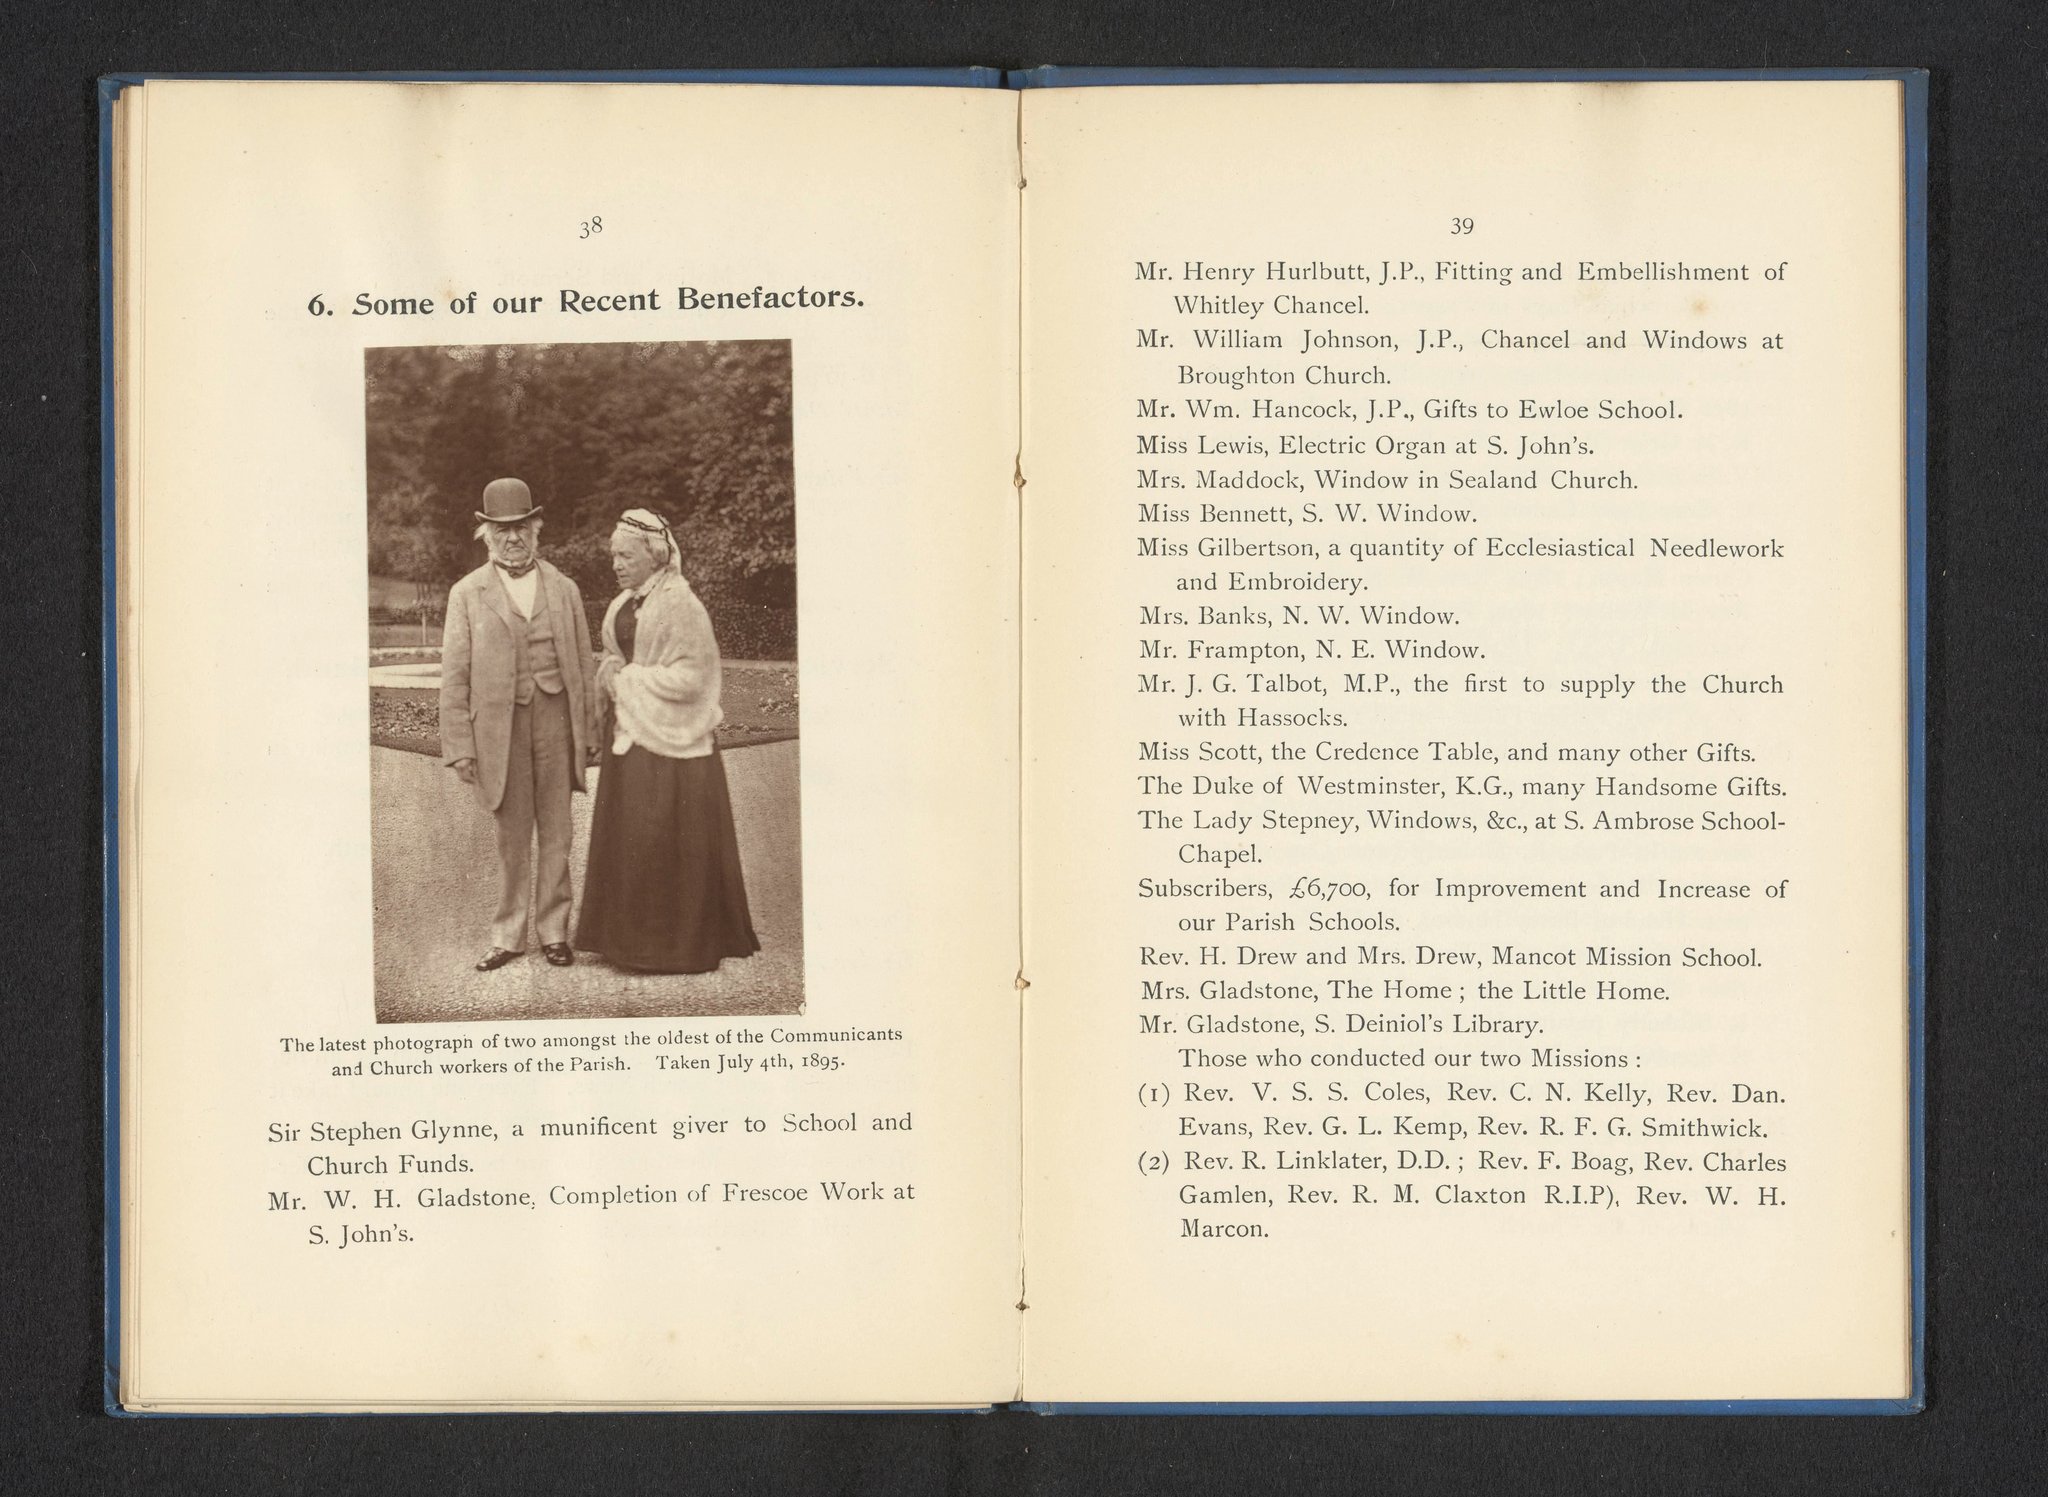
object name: page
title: Portret van twee liefdadigheidwerkers van de parochie van Hawarden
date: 1895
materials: paper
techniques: woodburytype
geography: wales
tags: anonymous historical person portrayed, charitable works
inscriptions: inscription: ‘The latest photograph of two amongst (...) Taken July 4th, 1895.’